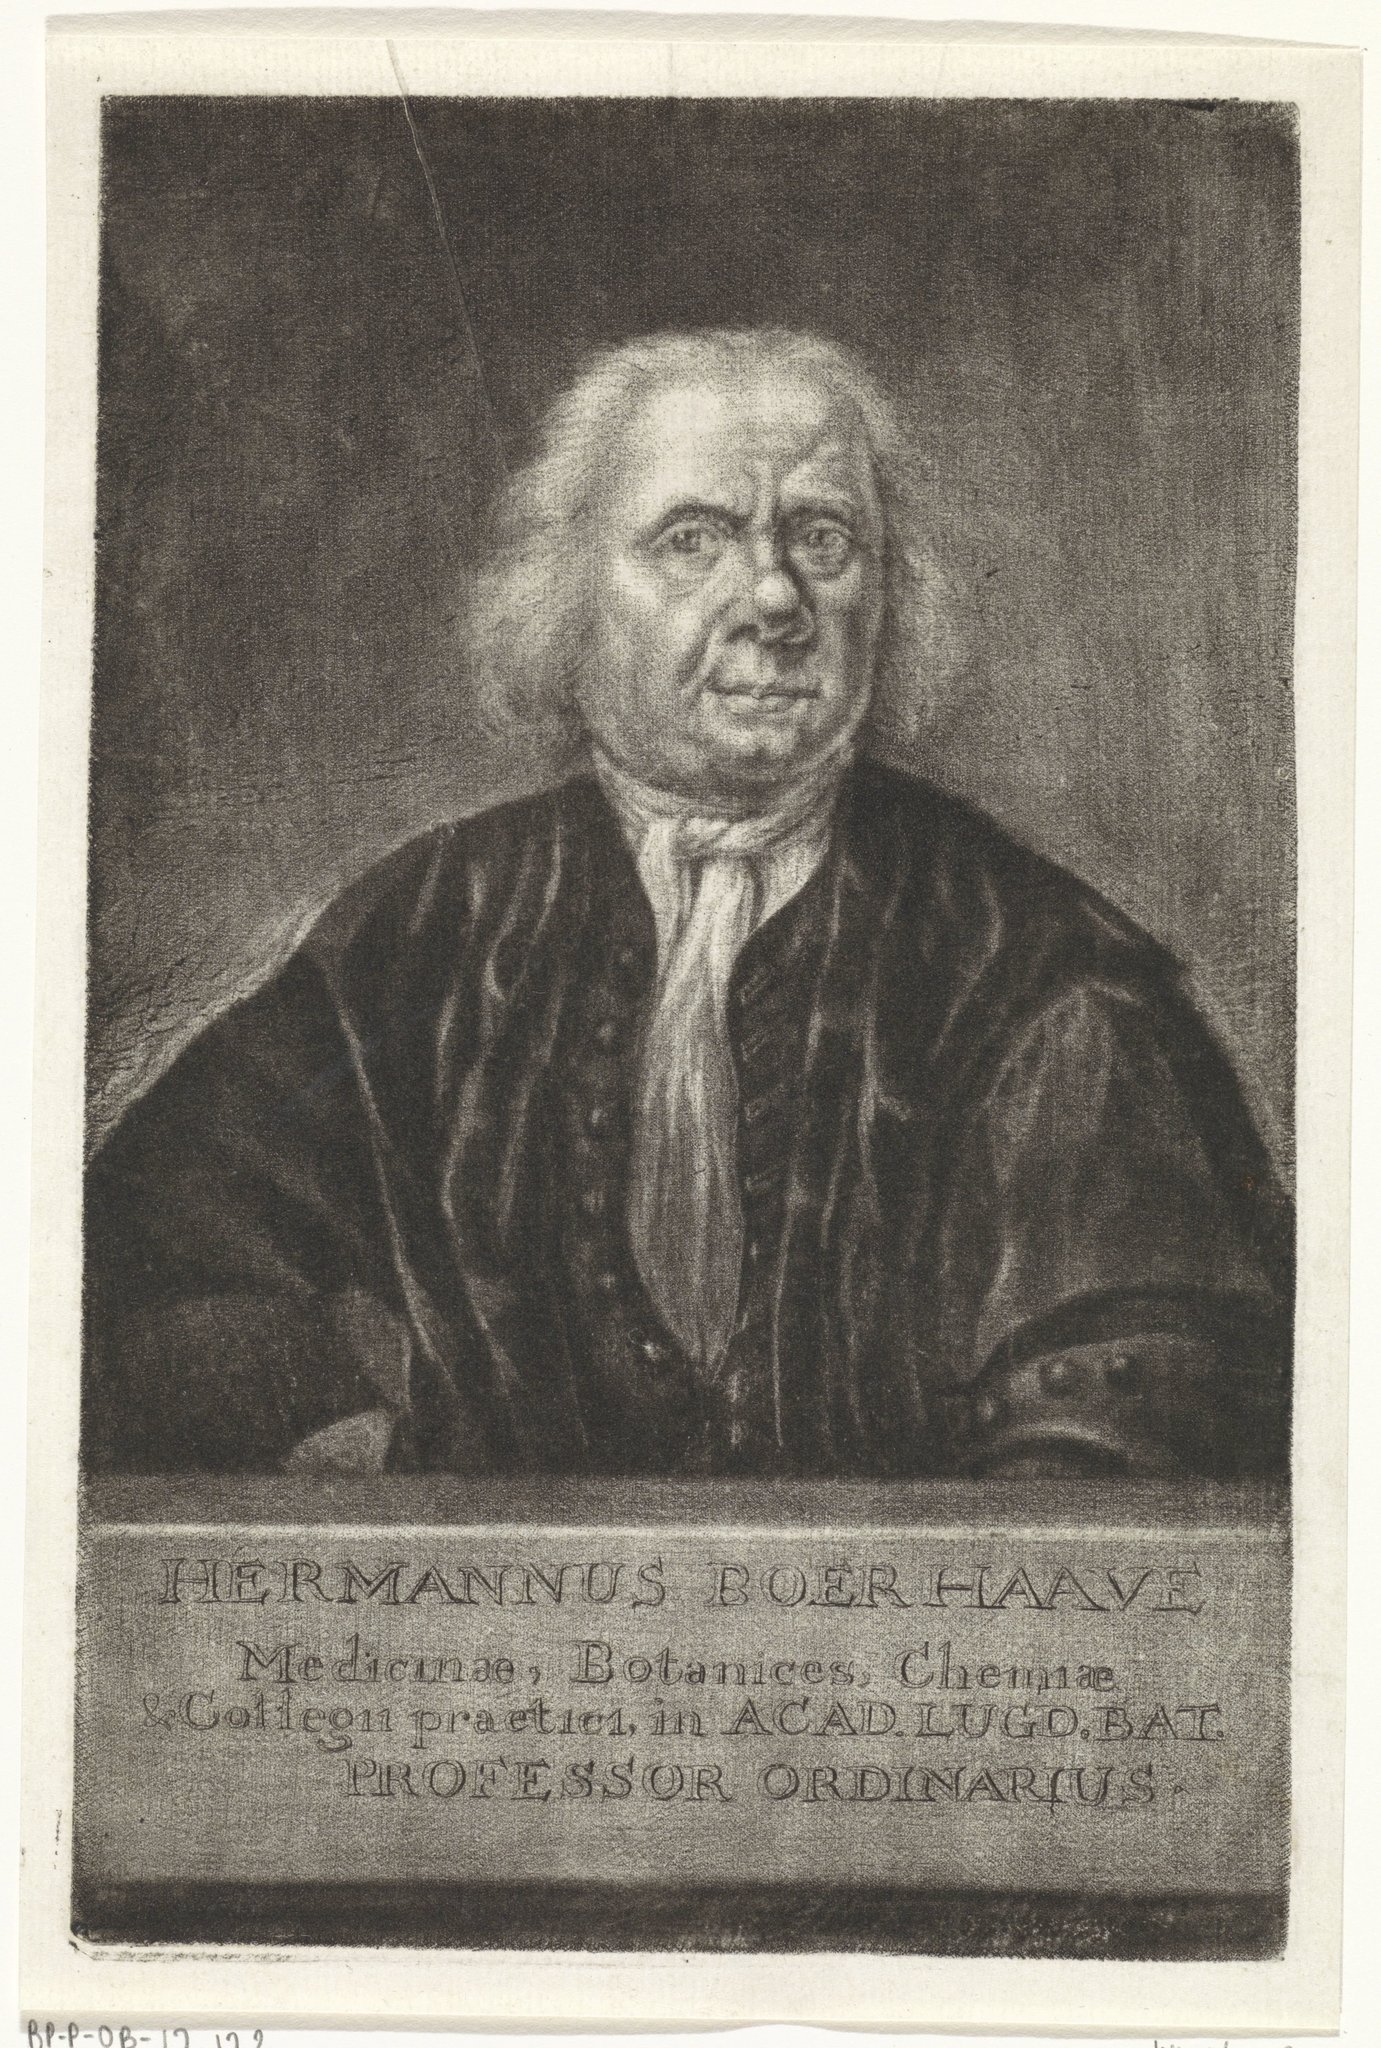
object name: print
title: Portret van Hermanus Boerhaave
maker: johannes de groot (ii)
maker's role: painter, print maker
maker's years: 1688-1796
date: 1722-1776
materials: paper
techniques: engraving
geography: northern netherlands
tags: hermanus boerhaave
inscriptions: collector's mark: Lugt 240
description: Hermanus Boerhaave, geneeskundige en hoogleraar aan de universiteit te Leiden.